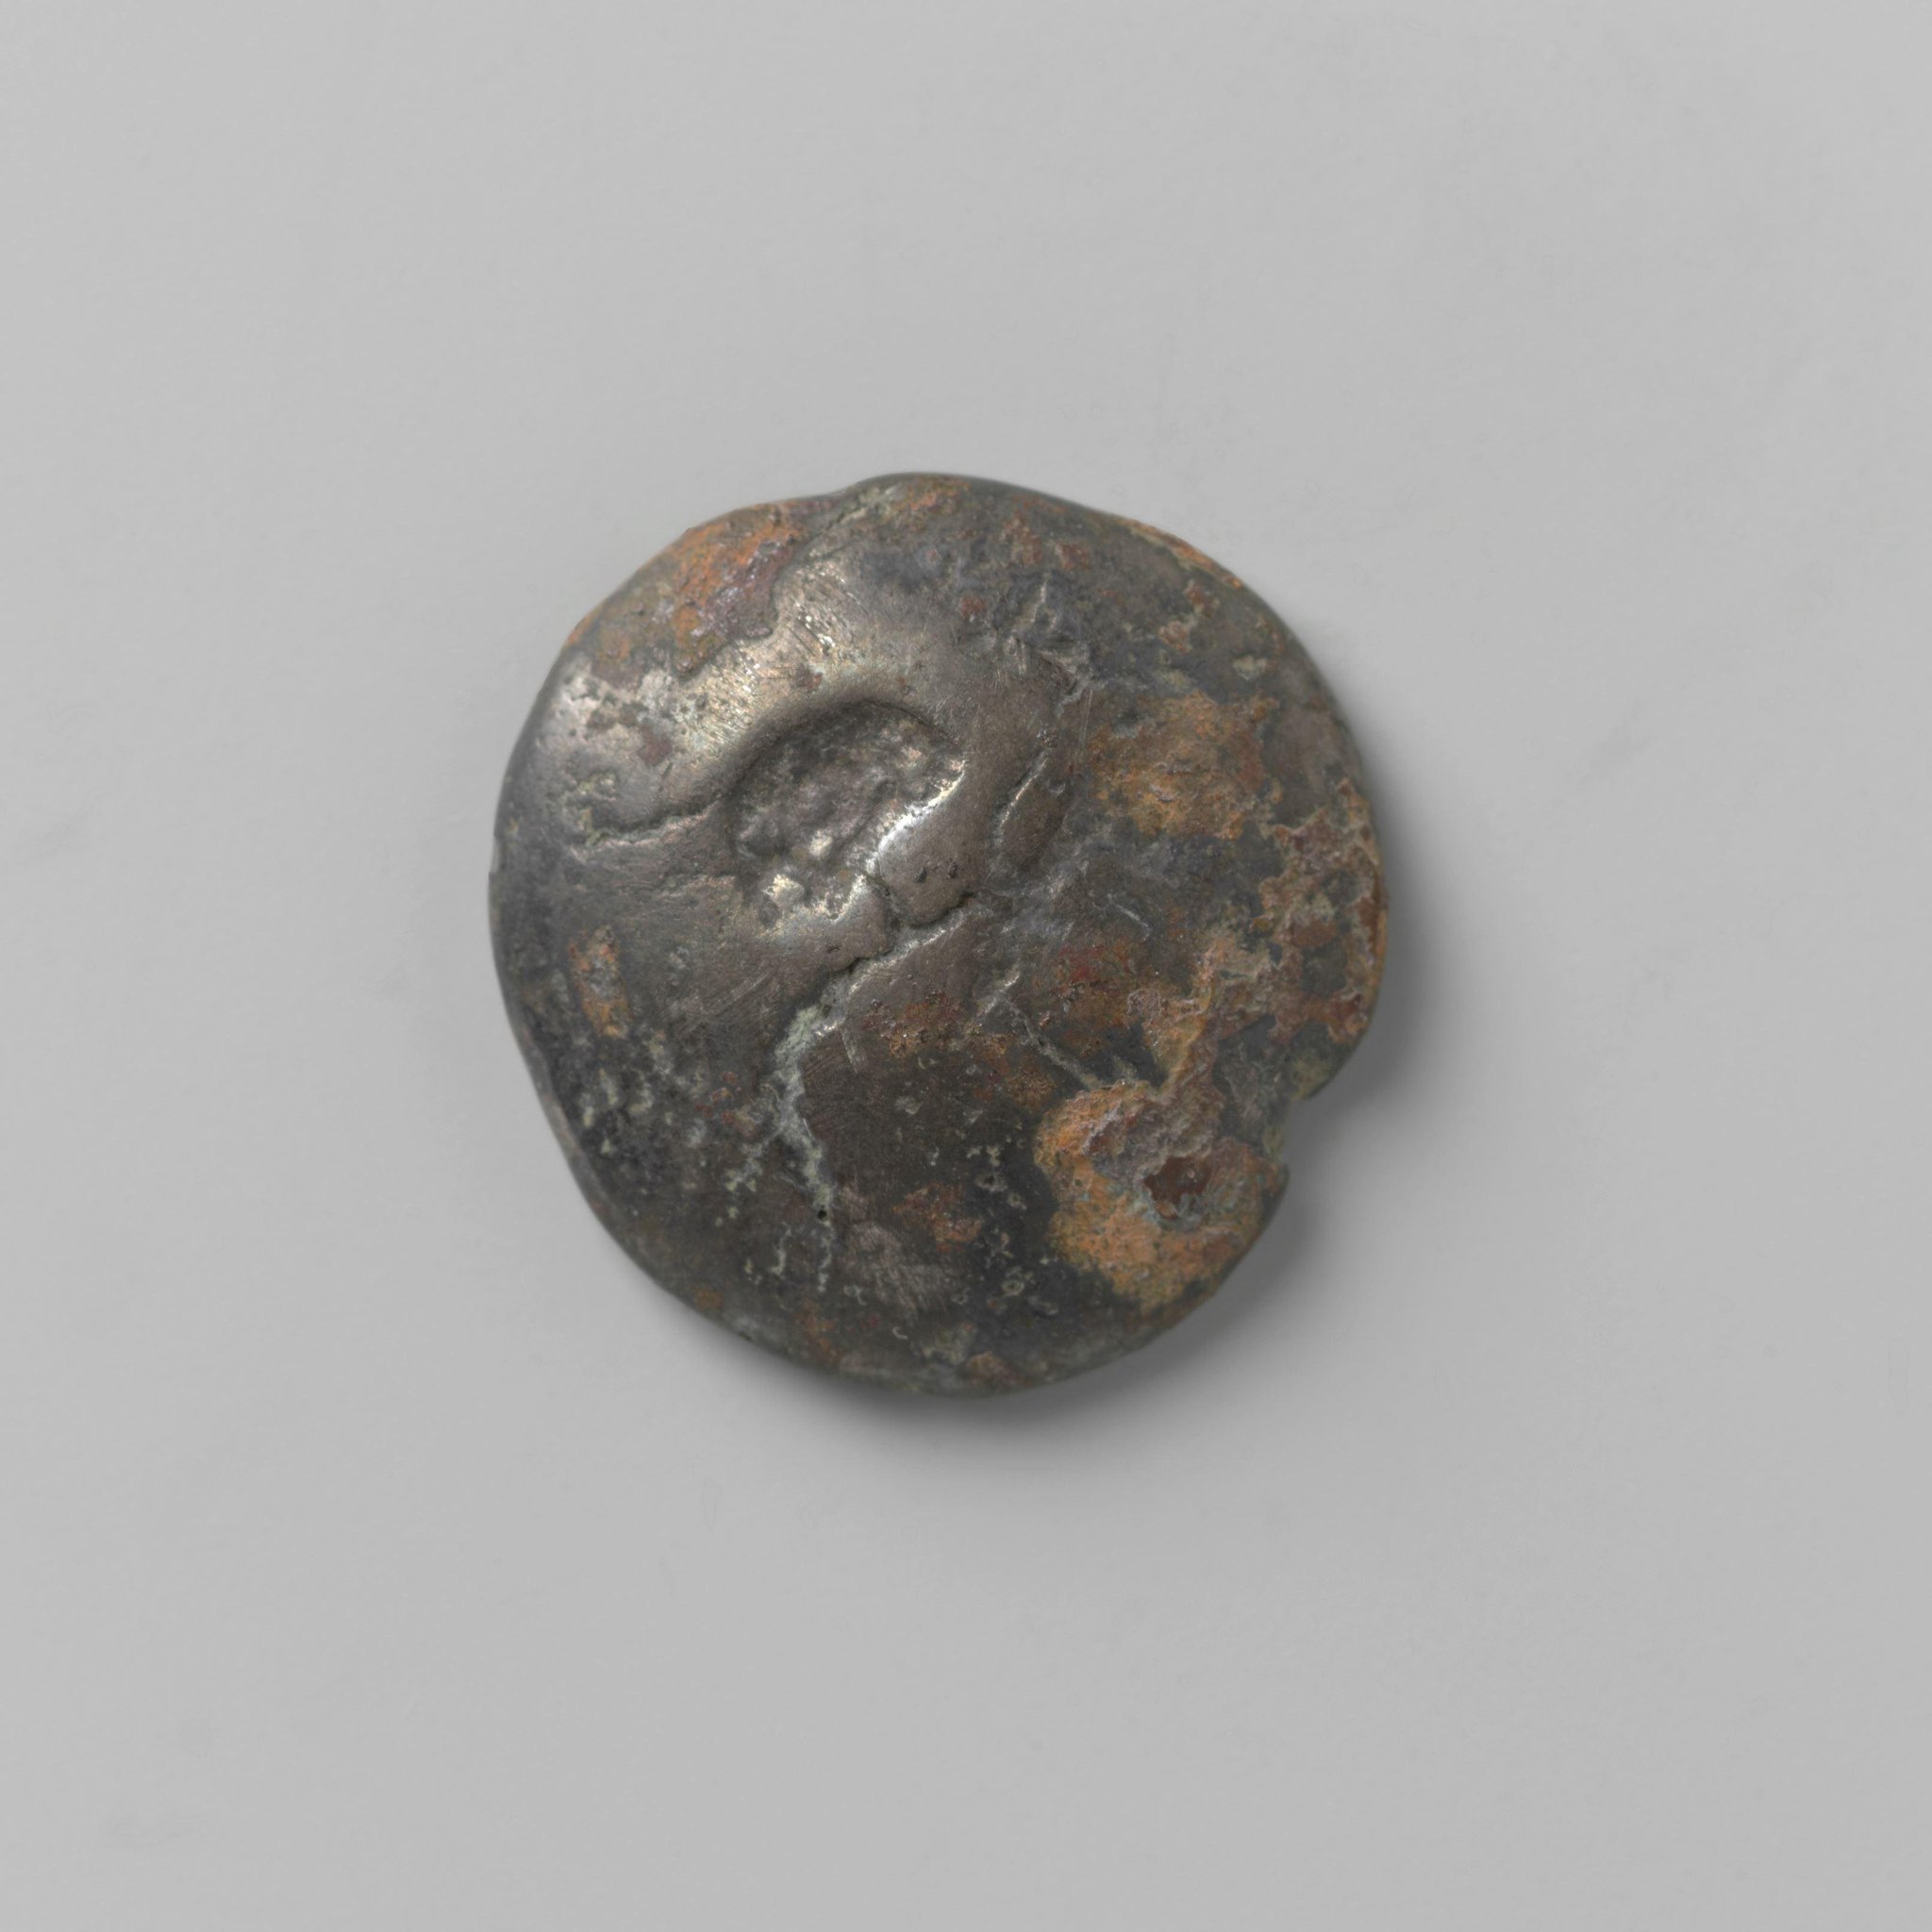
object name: coin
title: Java, koninkrijk Majopahit, djampel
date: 1290-1520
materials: silver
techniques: striking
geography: java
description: Zilveren schotelvormige munt. Voorzijde: letterteken in devanagari-schrift [maa?]. Keerzijde, figuratie [bloem?].